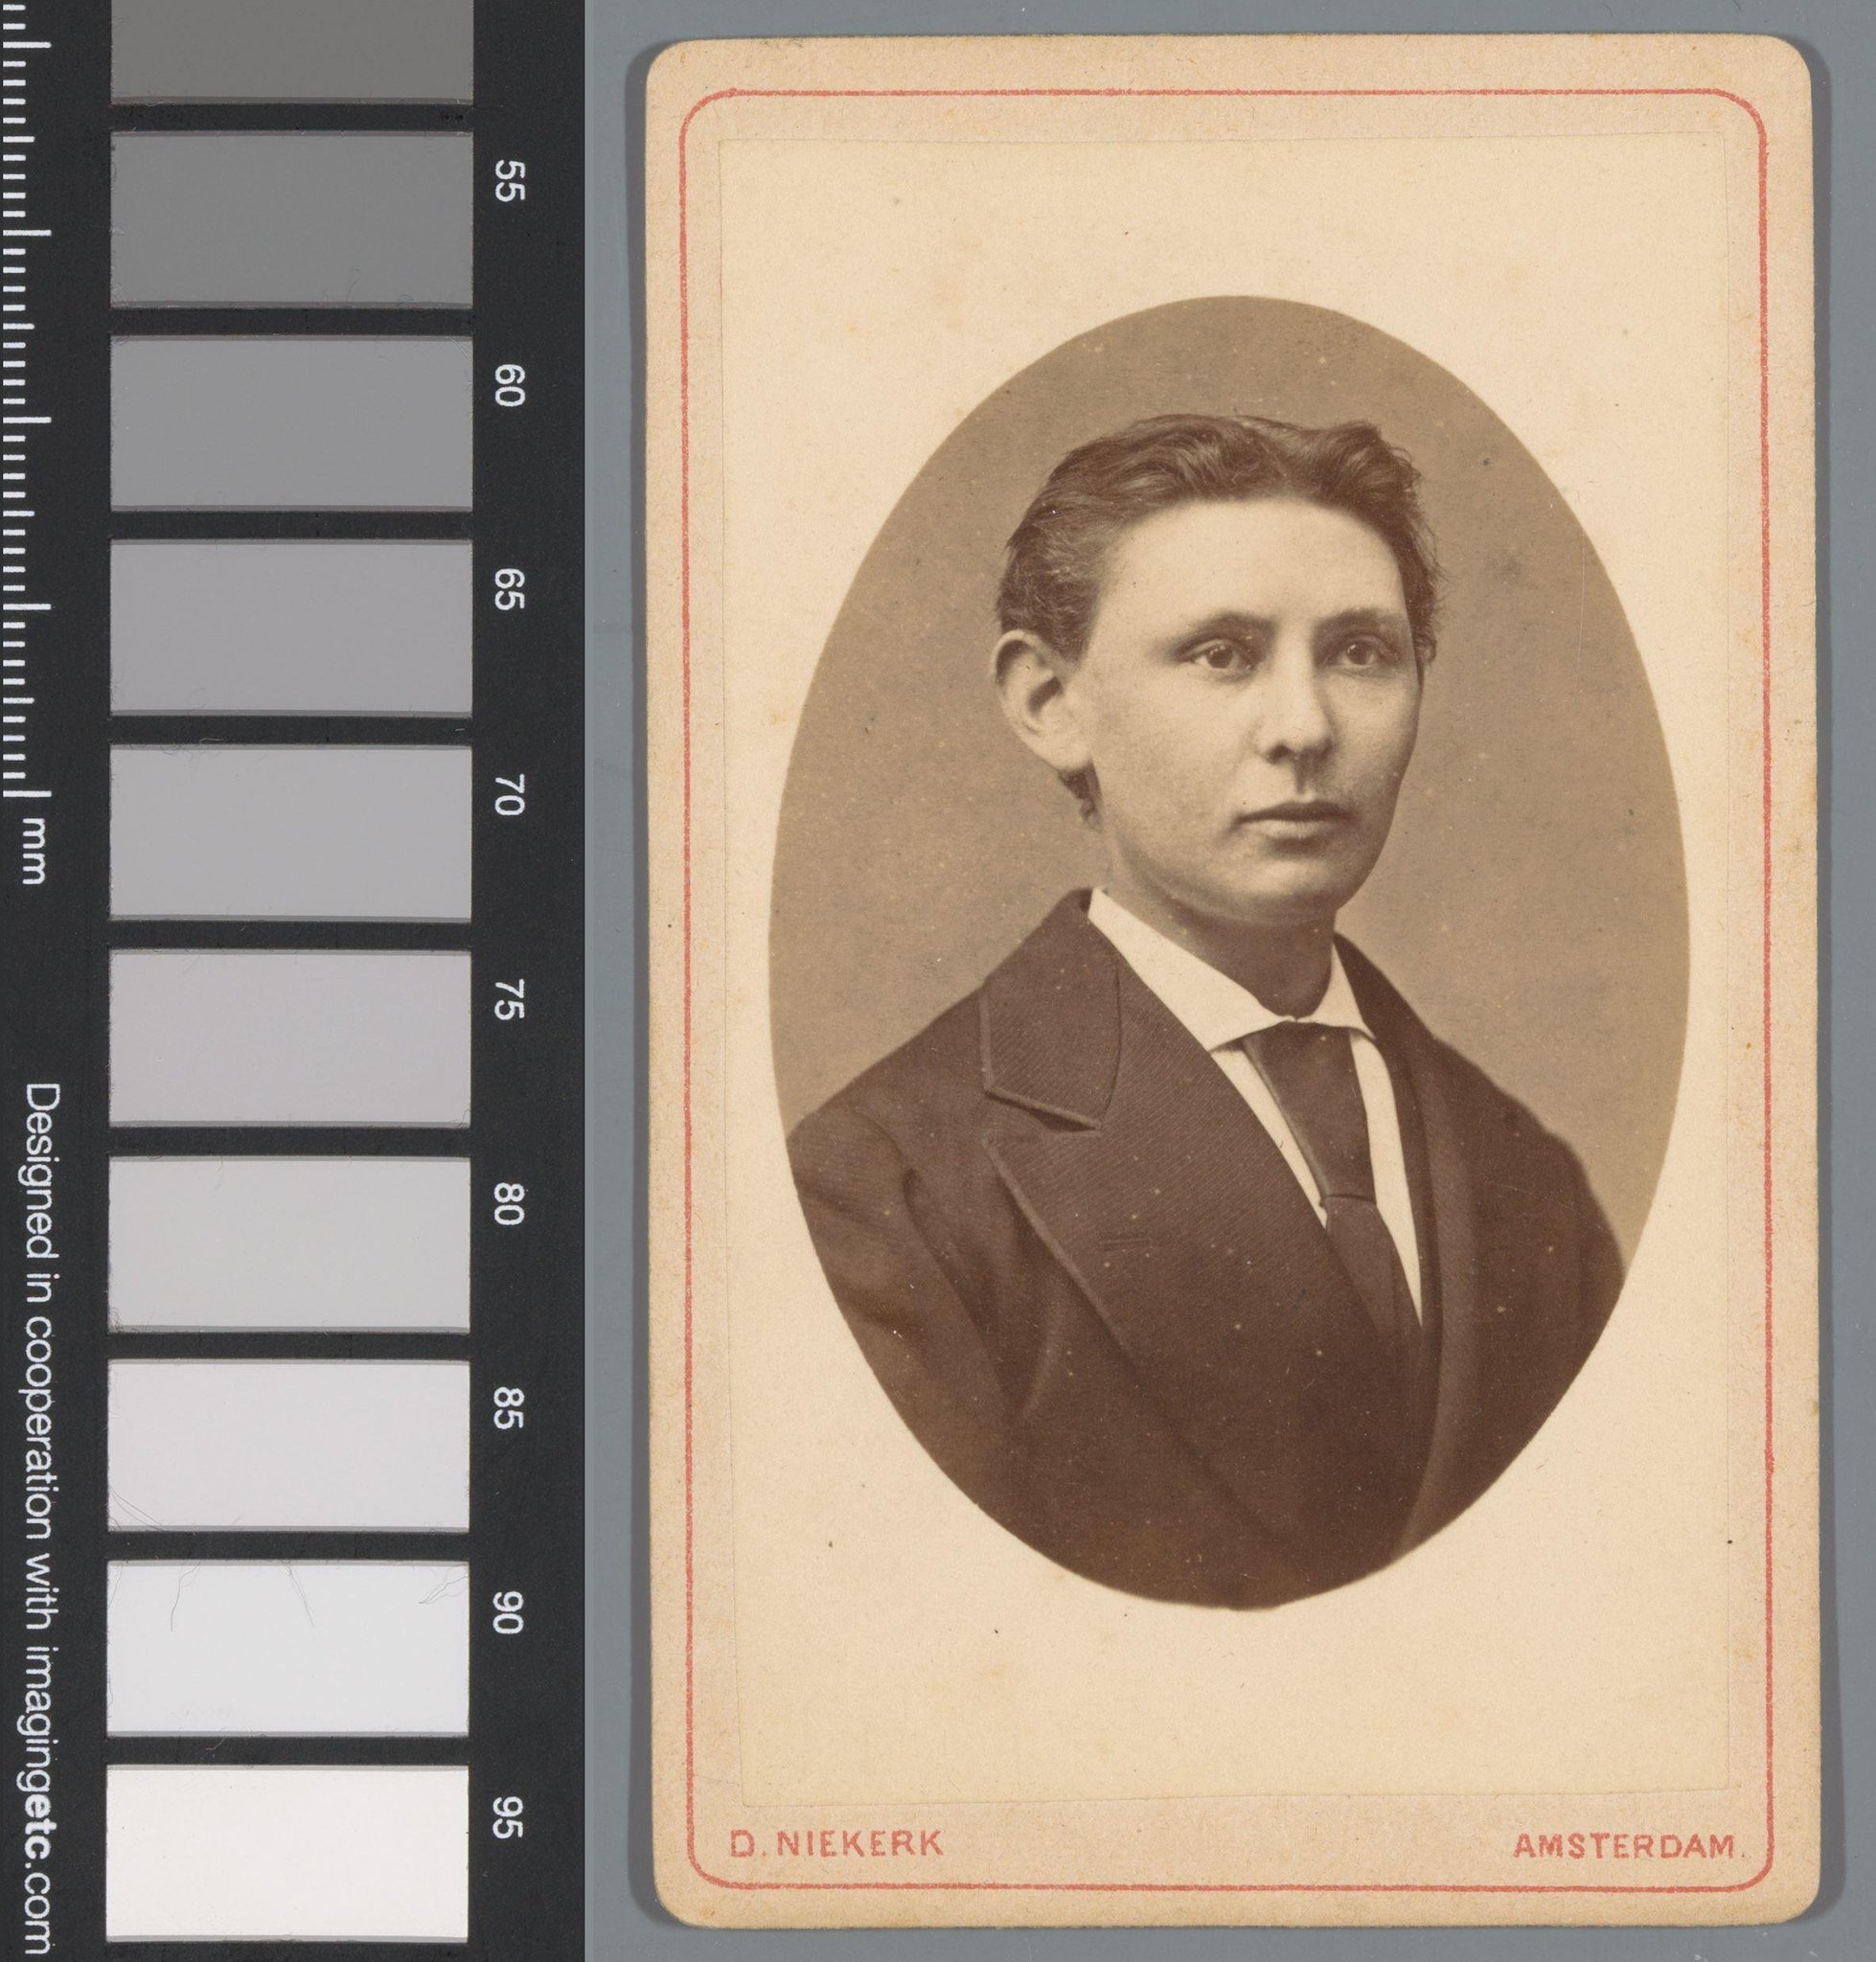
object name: carte de visite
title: Portret van een onbekende man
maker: dirk niekerk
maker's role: fotograaf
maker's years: 1824-1881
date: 1879-1881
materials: cardboard, paper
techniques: albumen print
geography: amsterdam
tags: historical persons, youth, adolescent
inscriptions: inscription: ‘NATIONALE TENTOONSTELLING 1875/ VERGULD ZILVER/ TWEE BRONZEN MEDIALLES/ INTERNATIONALE TENTOONSTELLING 1877/ D. NIEKERK./ Photograaf van Z.K.H. Prins Hendrik der Nederlanden./ ATELIERS./ Baangracht tusschen Leidsche Plein/ en Kruisstraat - 248./ en/ Oostenburgergracht - 3/ AMSTERDAM.’